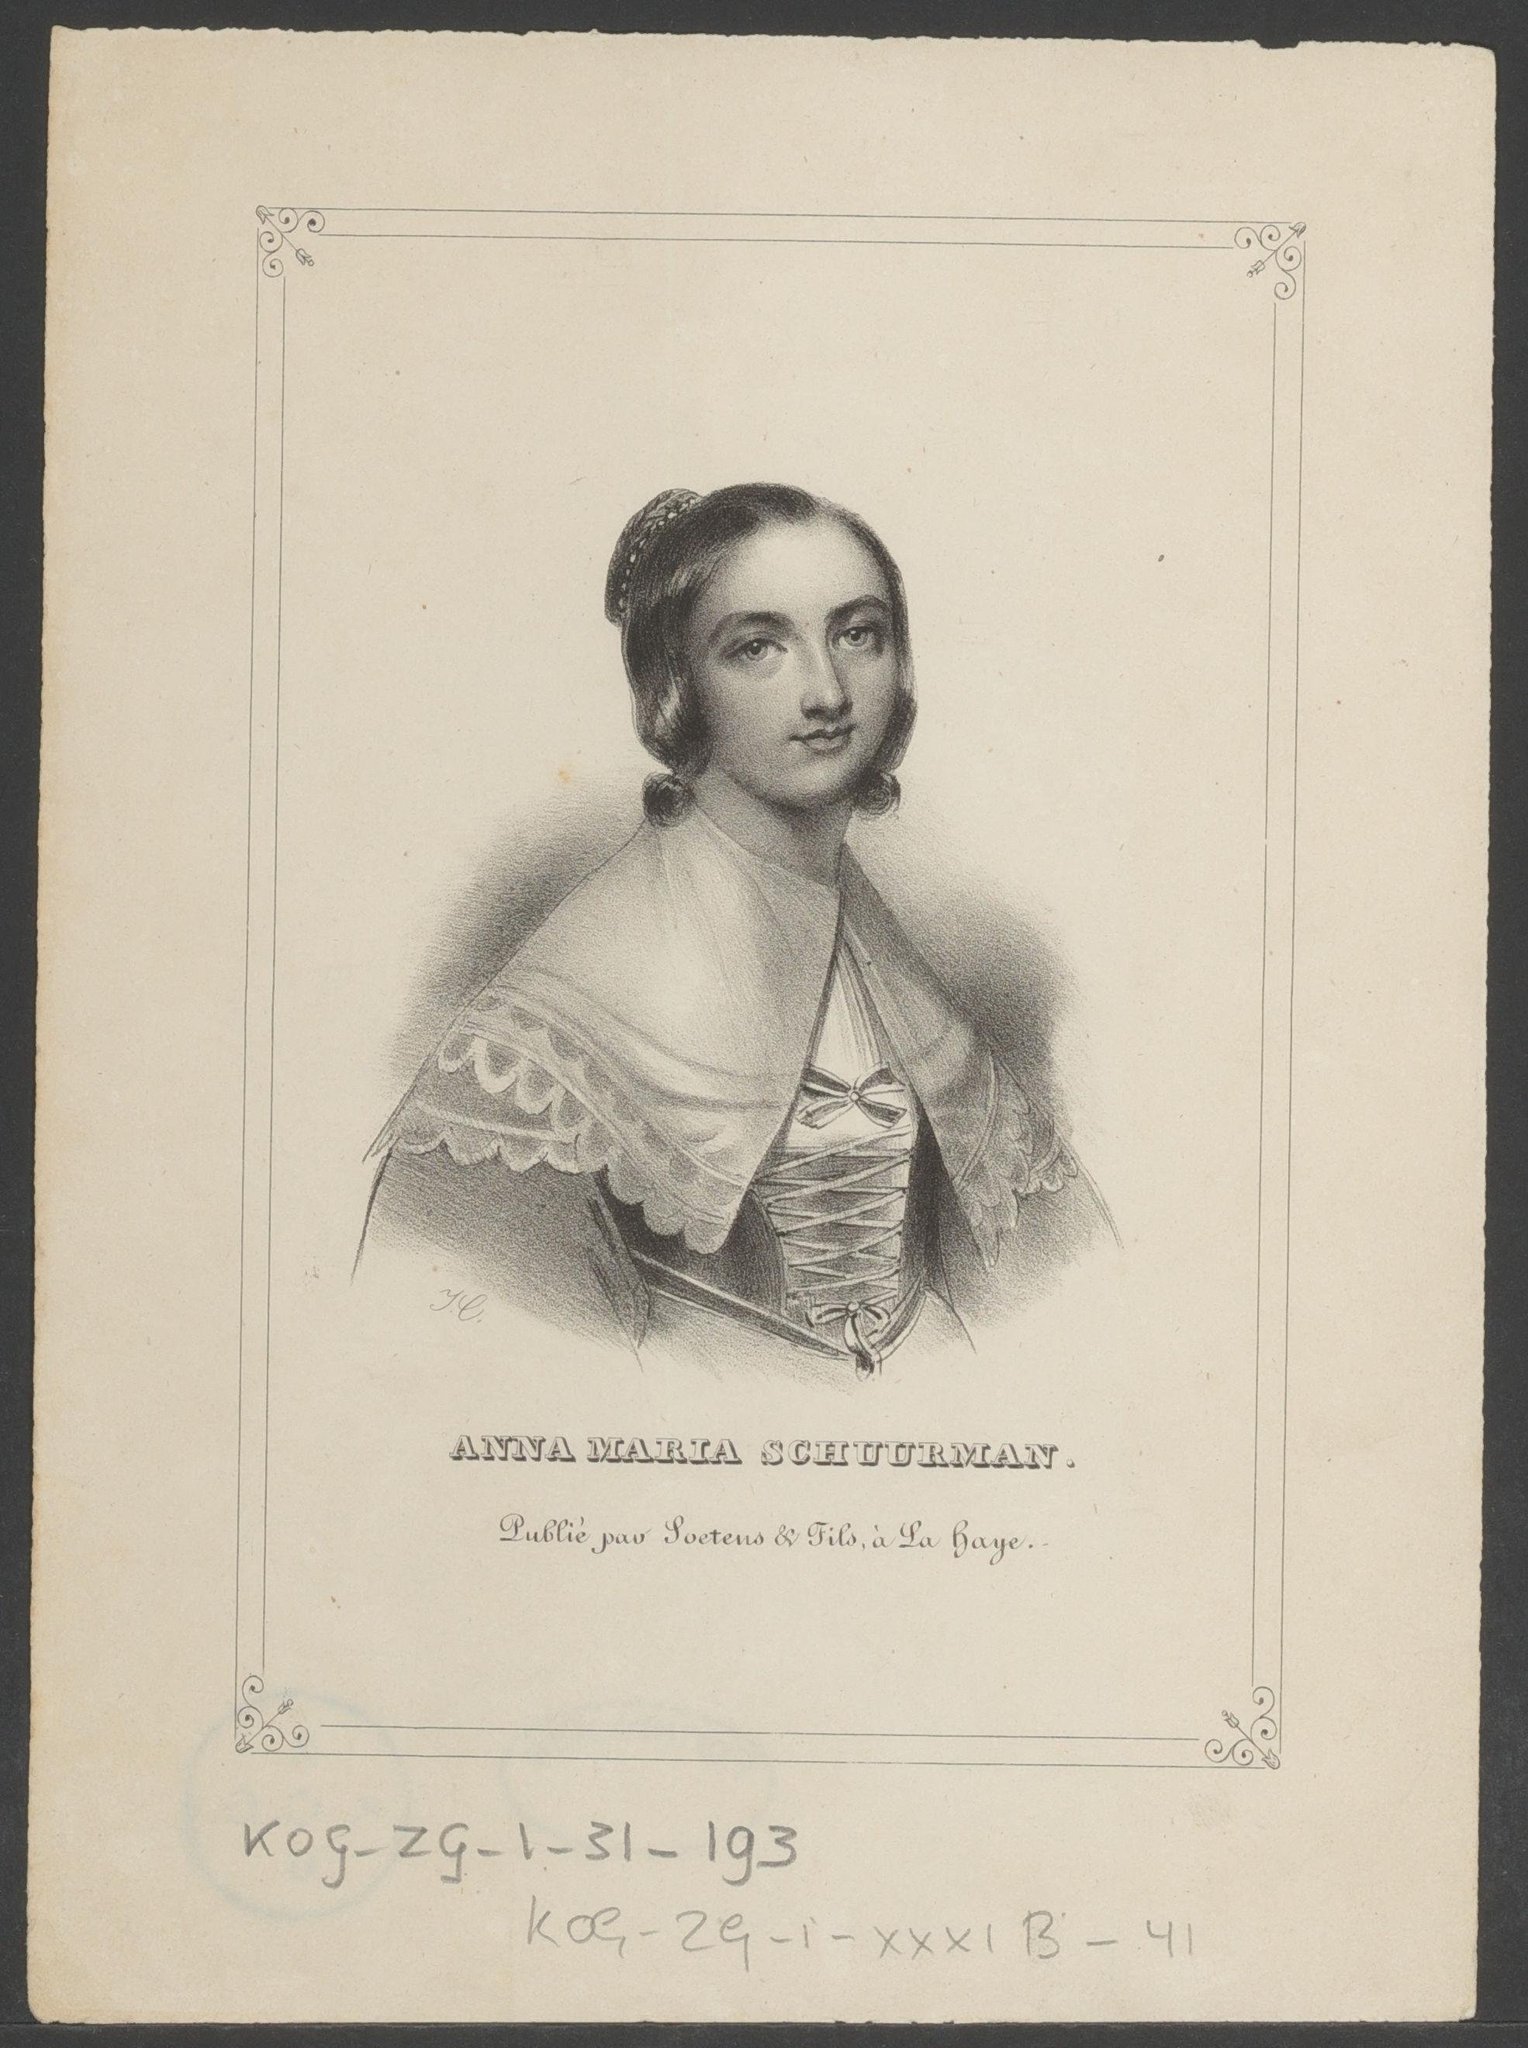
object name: print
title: Portret van Anna Maria van Schurman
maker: j.b. clermans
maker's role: print maker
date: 1836-1899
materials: paper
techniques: lithograph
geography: the hague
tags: cologne, print maker, draughtsman, anna maria van schurman, historical persons - bb - woman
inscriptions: collector's mark: Lugt 1641, stamp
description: Onderwerpsrubrieken binnen de Atlas Zeden en Gewoonten: Portretten, Portretten van bijzondere personen.